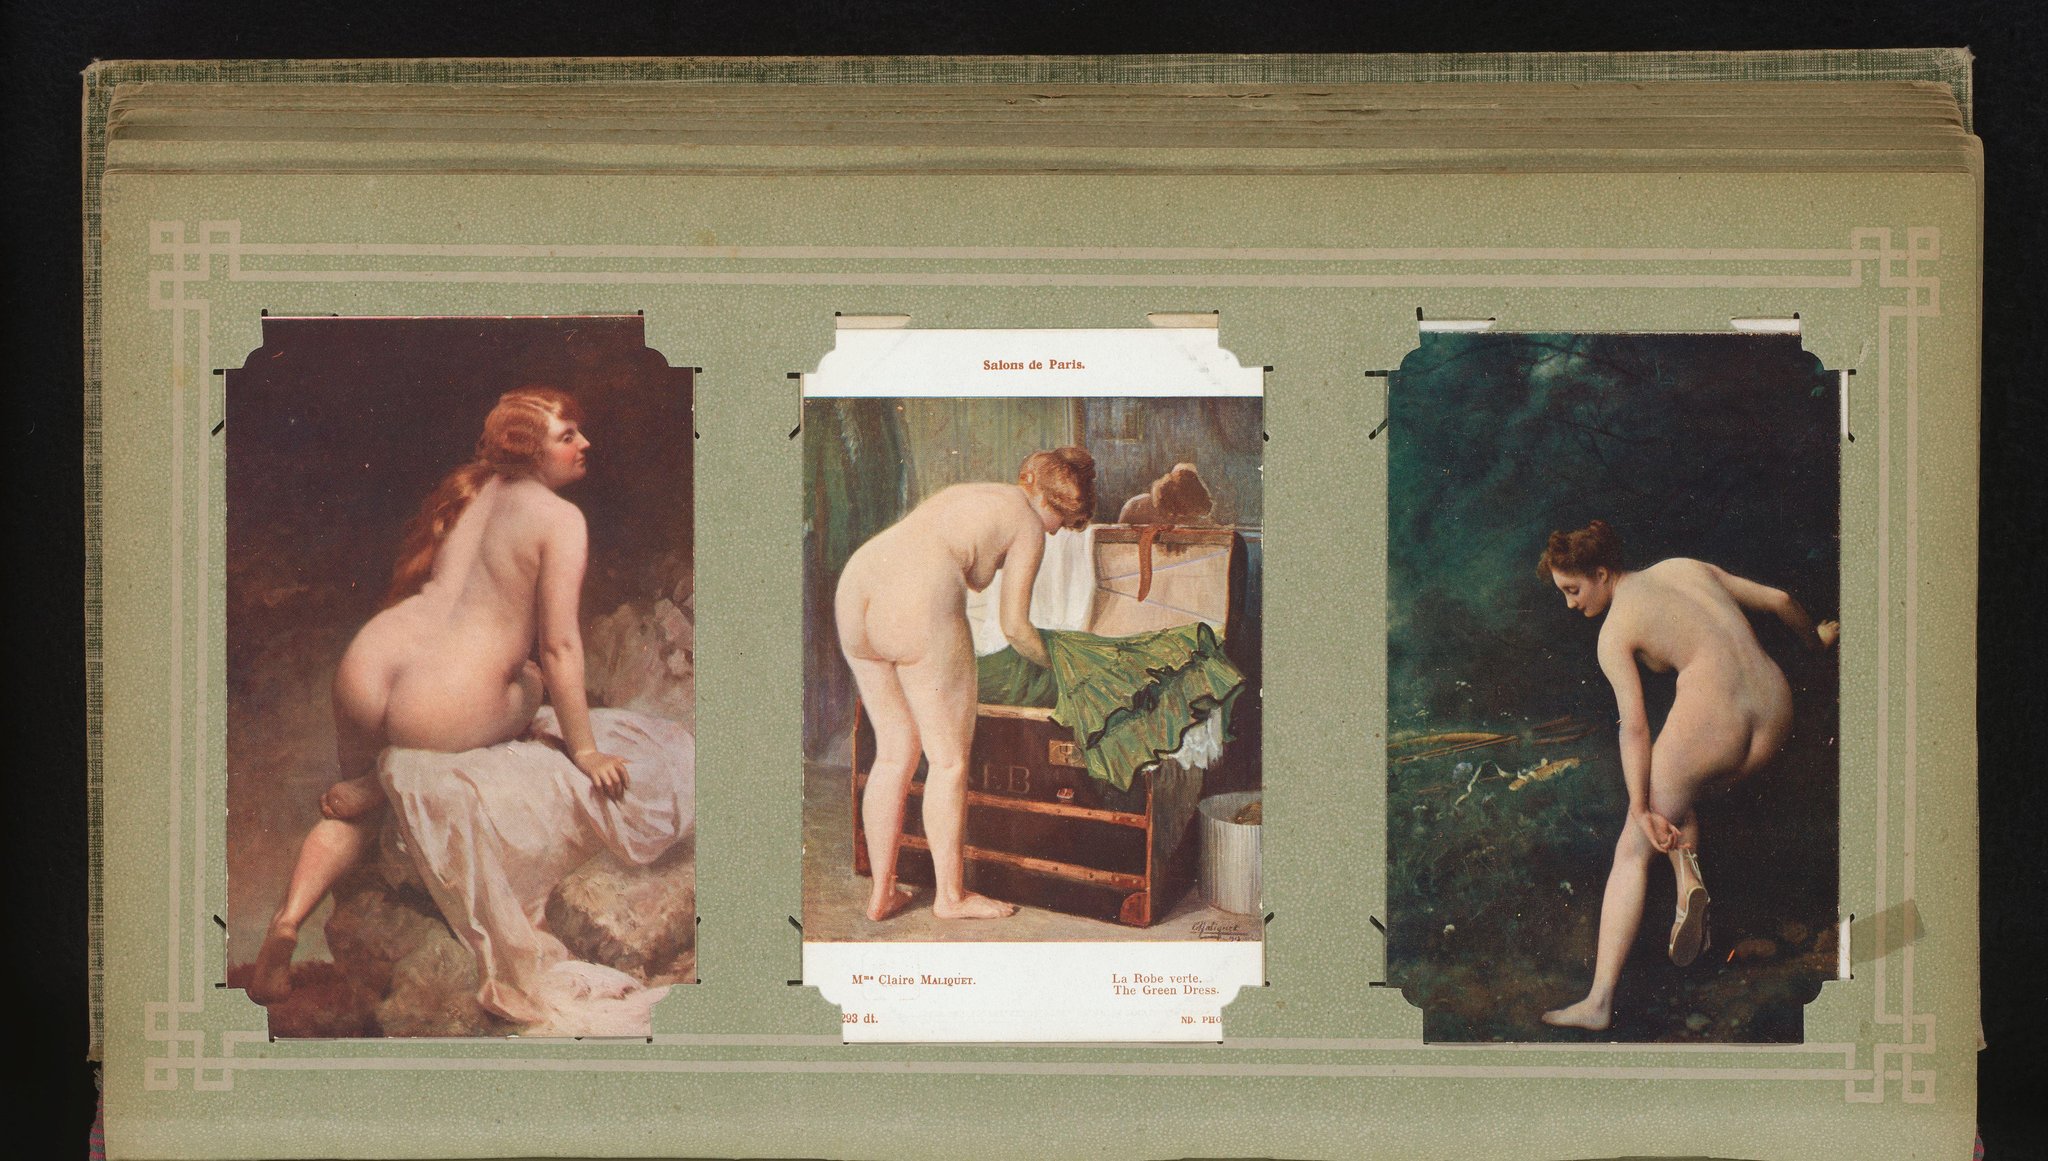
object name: ansichtkaart, prentbriefkaart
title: Drie reproducties van geschilderde portretten van naakte vrouwen, waarvan één door Claire Maliquet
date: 1900-1930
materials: cardboard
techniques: three-color autotype, four-color autotype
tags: historical persons - bb - woman, woman (showing herself) undressed, quasi-nude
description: Deze prenten maken deel uit van een album.